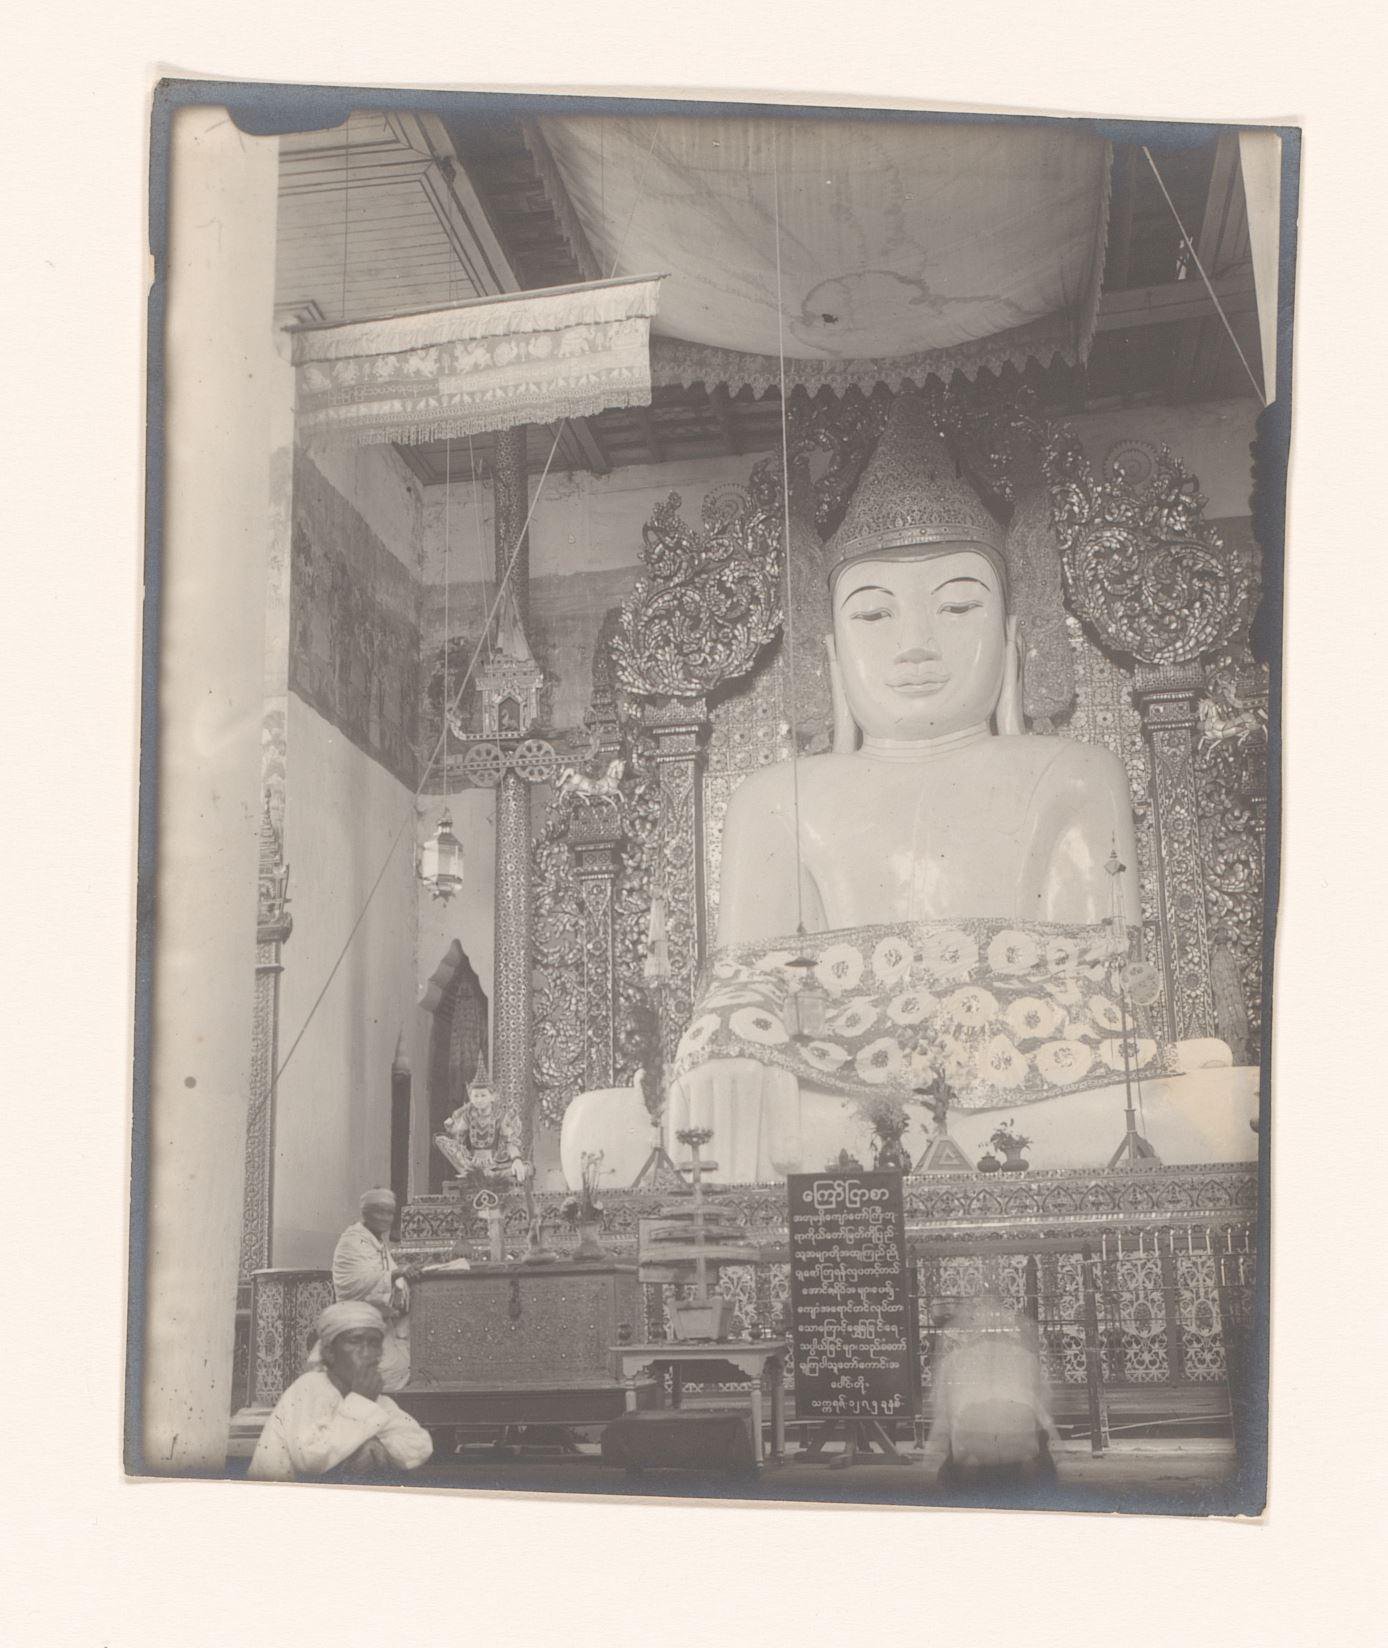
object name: photograph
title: Interior of a Buddhist shrine with an image of Buddha, Myanmar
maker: jan adriani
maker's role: fotograaf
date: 1907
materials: photographic support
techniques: gelatin silver print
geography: myanmar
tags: places and objects of worship ~ hinduism, buddhism, jainism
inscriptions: inscription: ‘50/ AI 74’